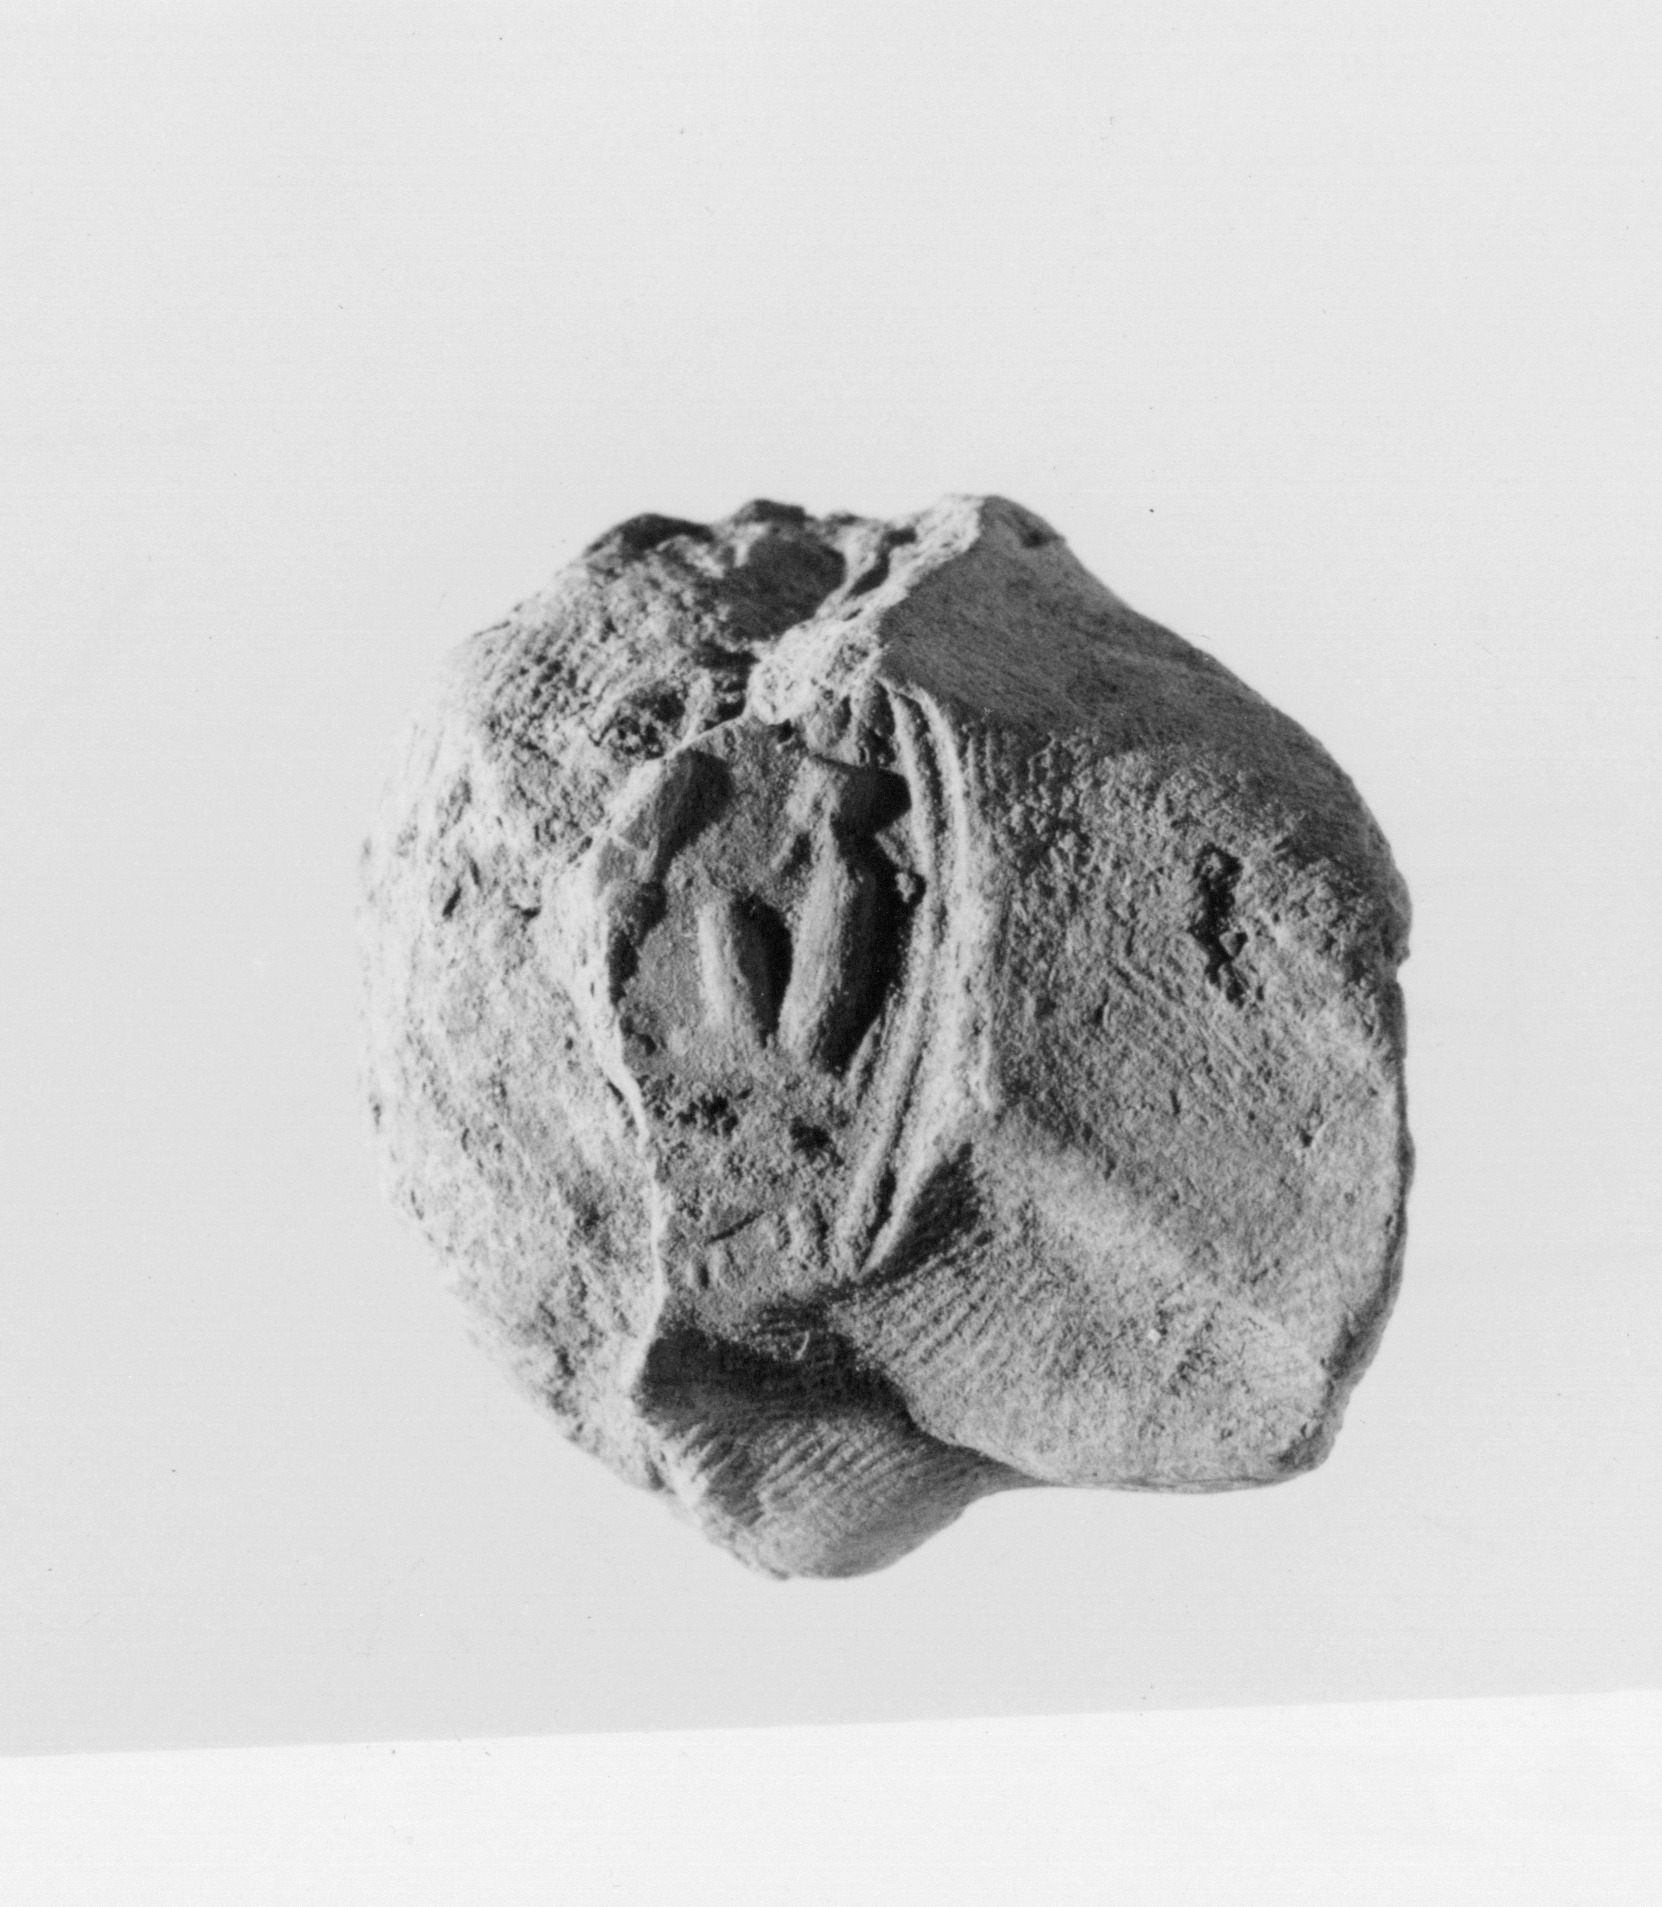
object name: sealing, nebmaatre, amenhotep iii, horus, re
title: Document Sealing With the Throne Name of Amenhotep III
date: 1390-1352 BCE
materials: mud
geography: egypt